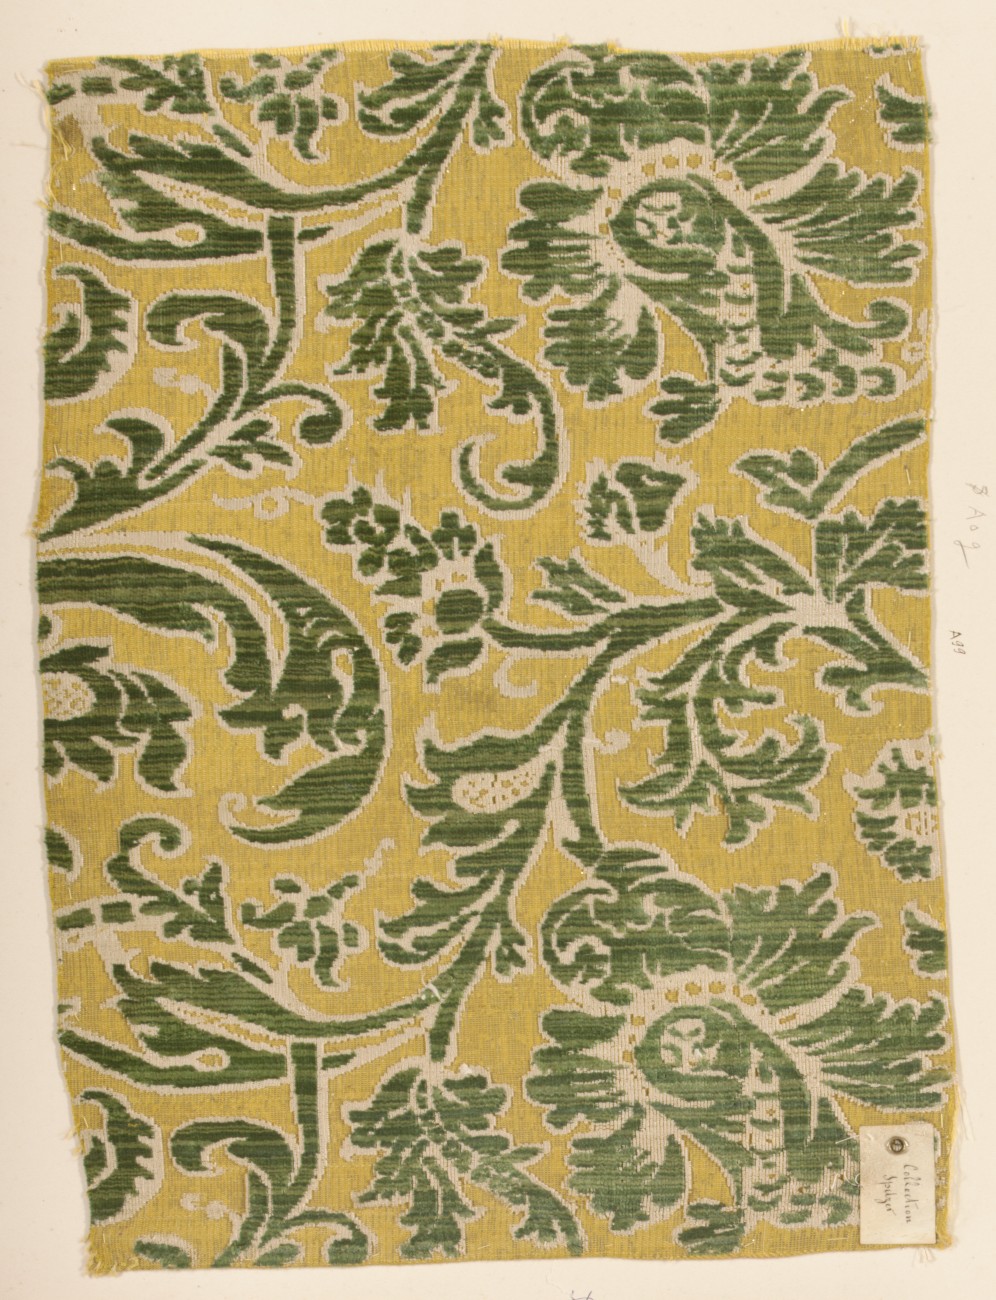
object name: fragment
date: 1567-1700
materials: metal thread, silk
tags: flowers,leaves